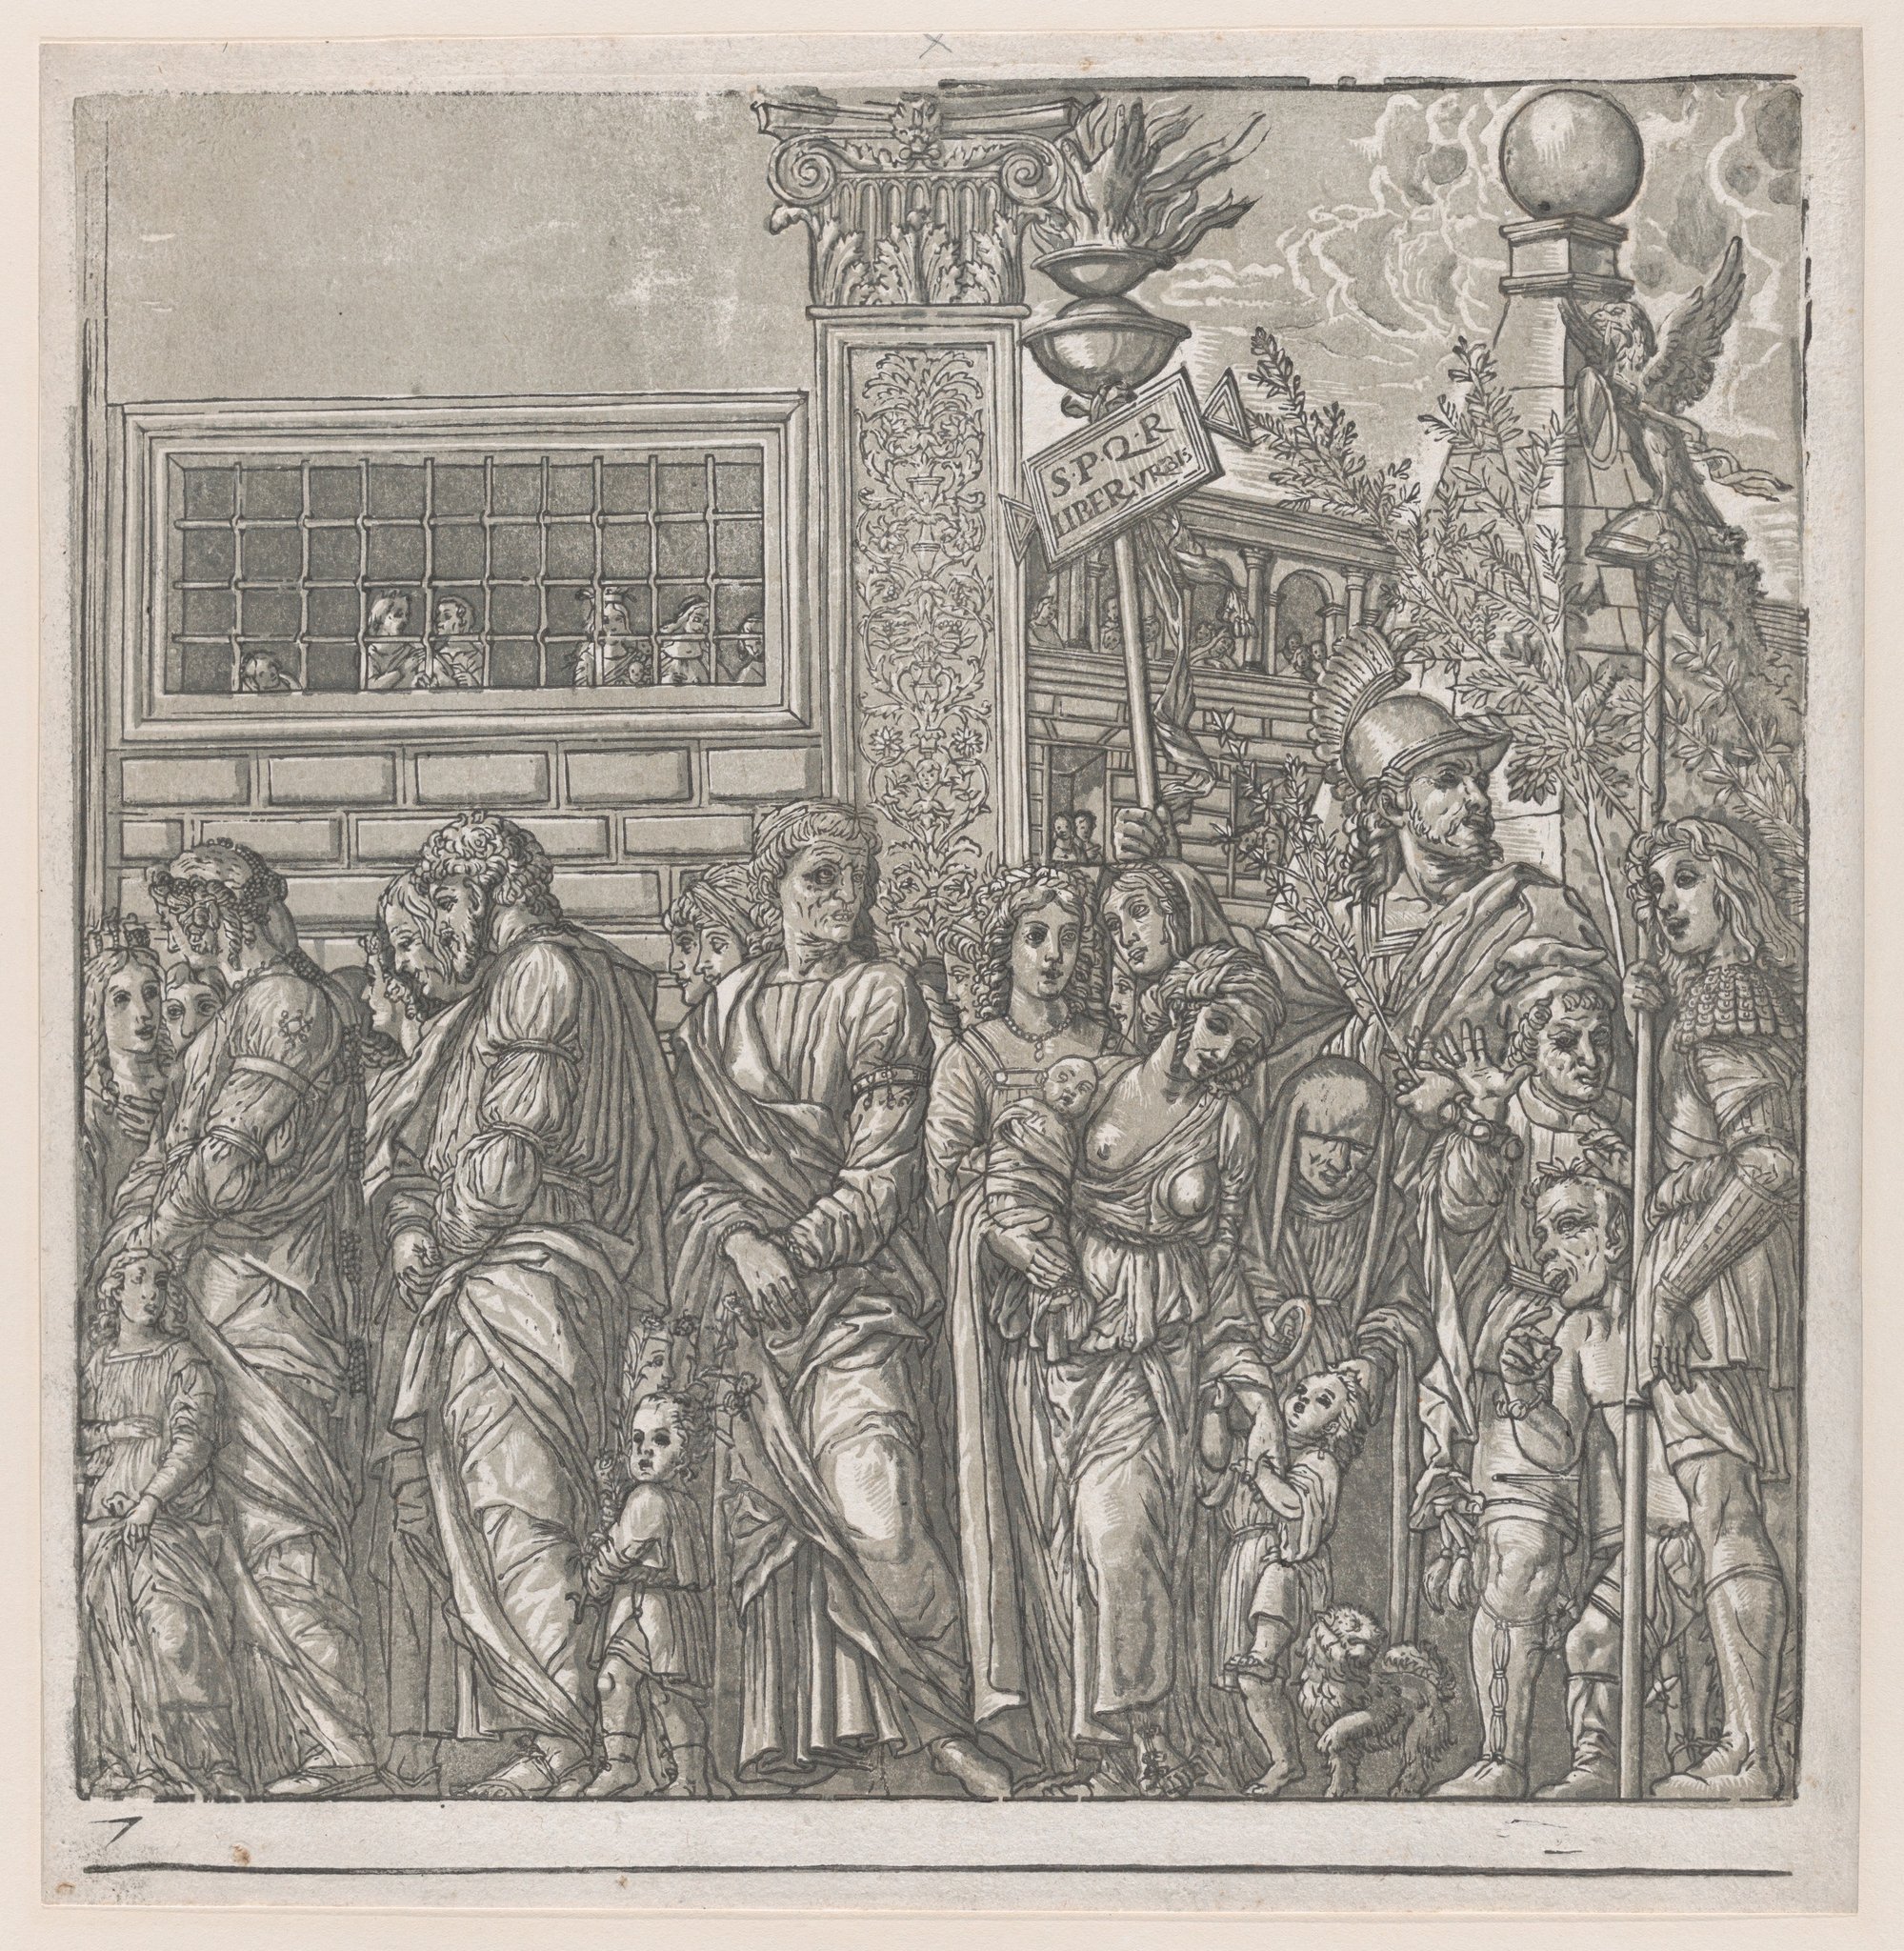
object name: print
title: Sheet 7: Procession, from "The Triumph of Julius Caesar"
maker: andrea andreani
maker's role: artist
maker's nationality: italian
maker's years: 1558-1629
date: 1599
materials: ink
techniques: woodcut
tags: soldiers,boys,infants,men,women